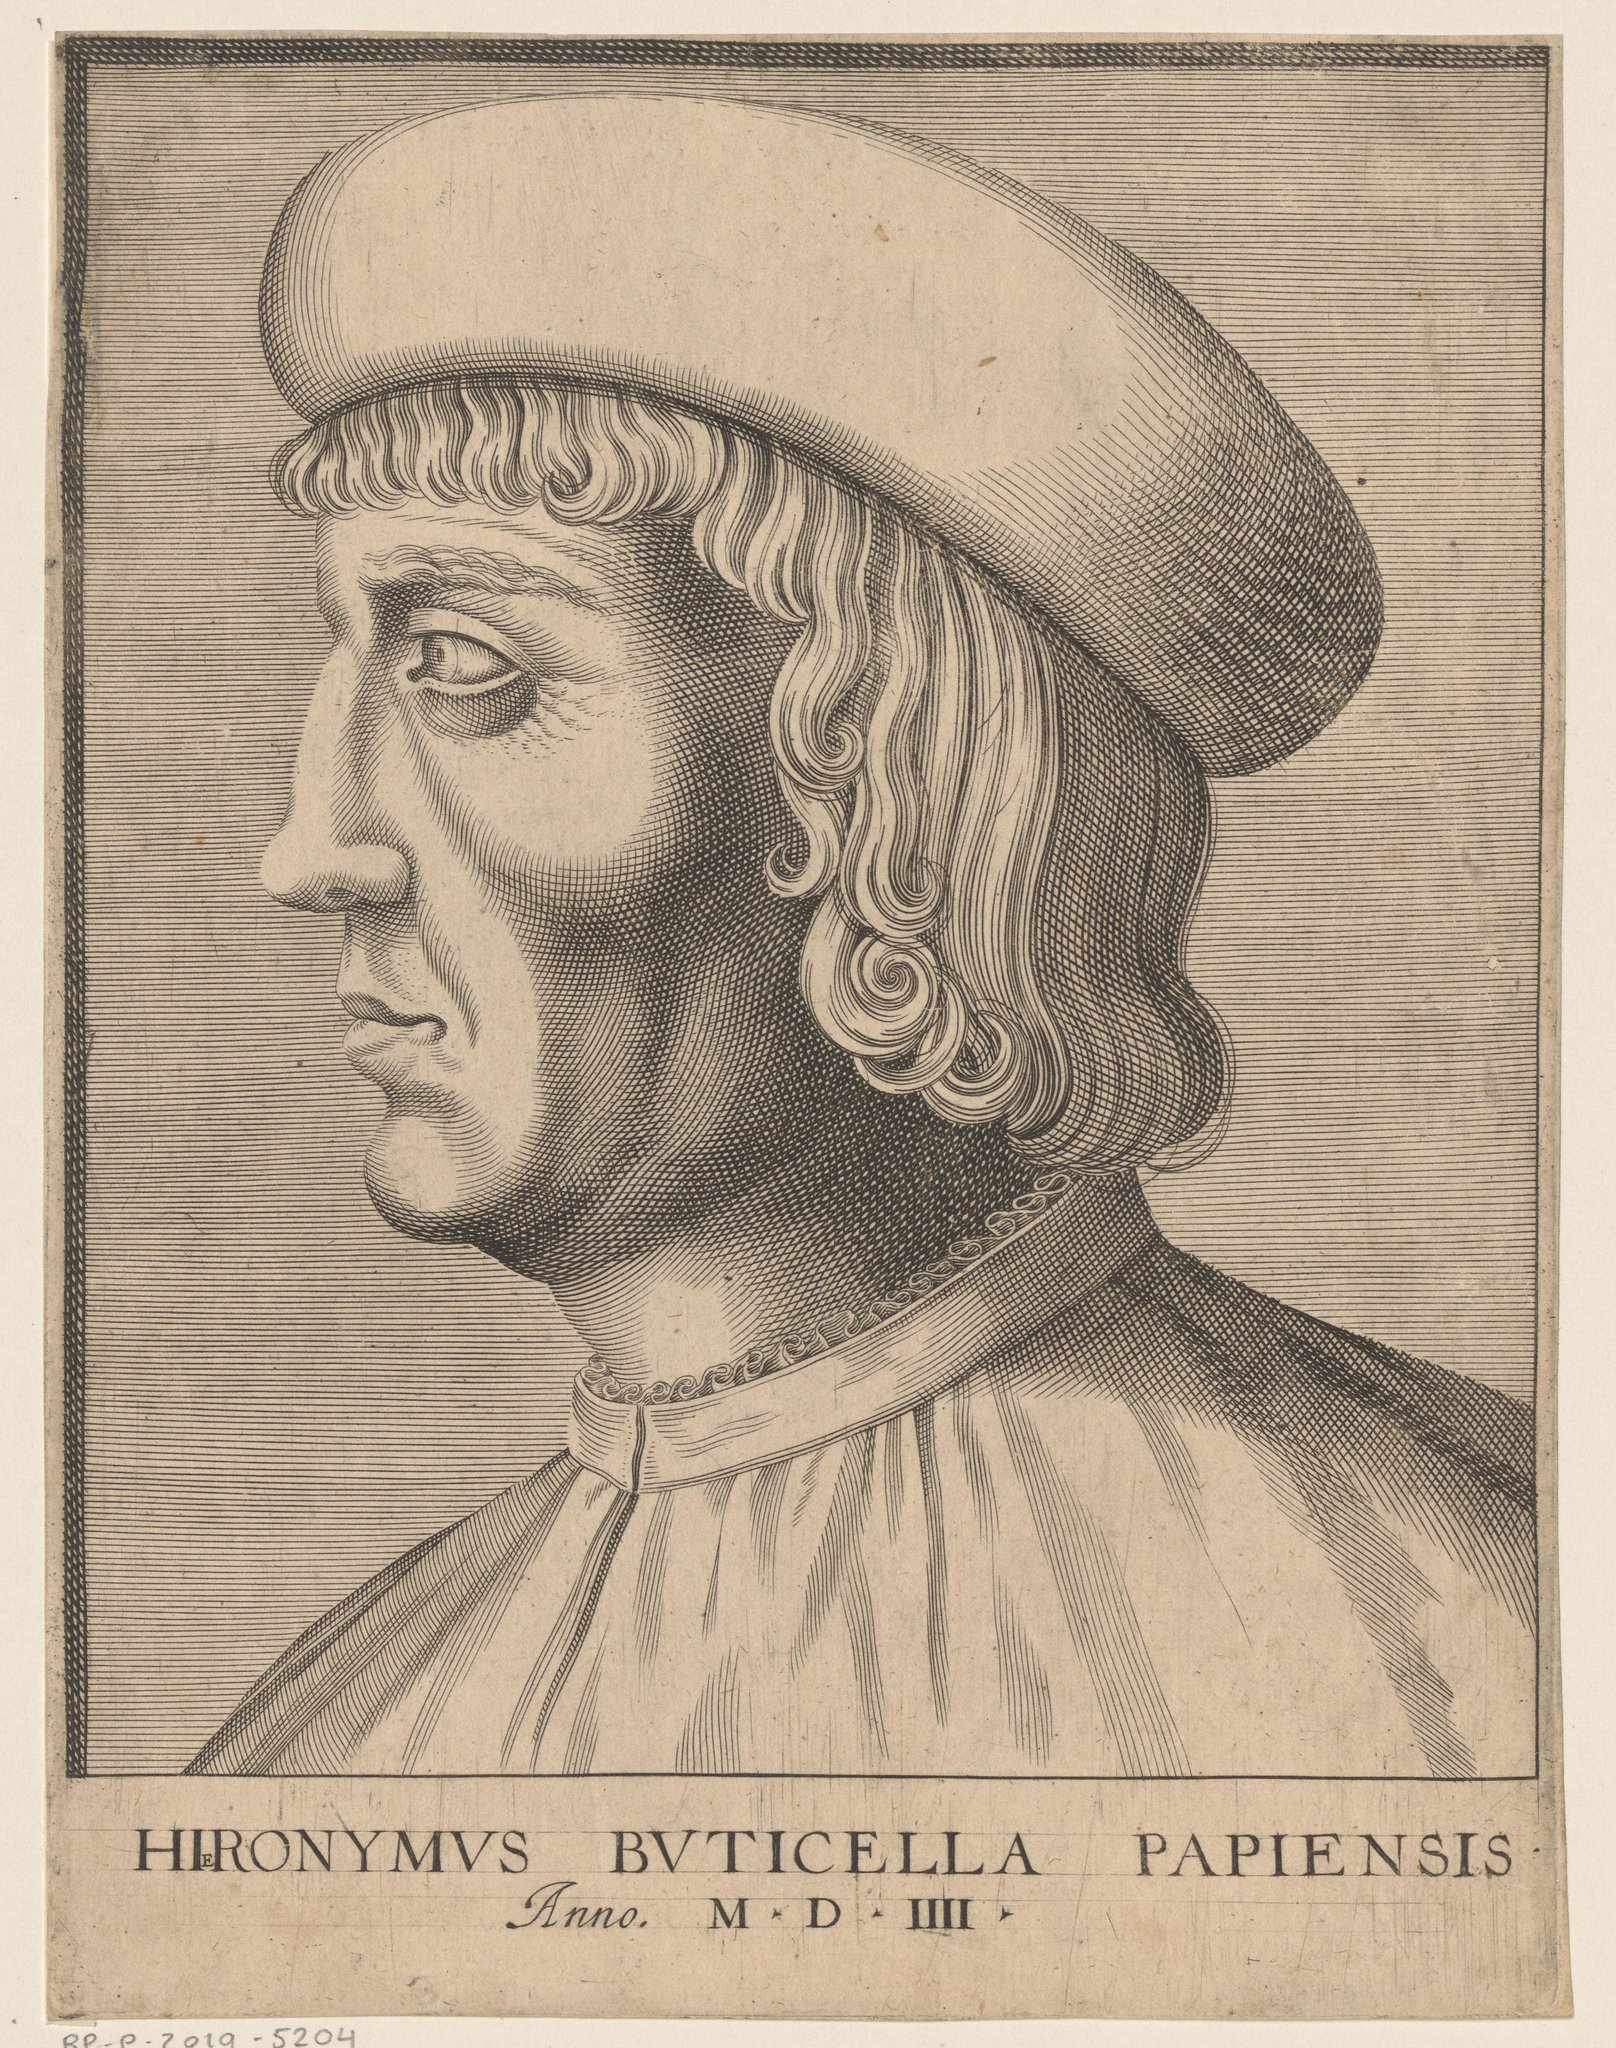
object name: print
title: Portret van Girolamo Bottigella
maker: Anonymous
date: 1566-1599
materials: paper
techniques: engraving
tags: rome, historical persons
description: Kopie (gespiegeld) naar prent uit: Benavides, Marco Mantova. Illustrium jureconsultorum imagines quae inveniri potuerunt ad vivam effigiem expressae (...). Rome: Antonio Lafreri, 1566.